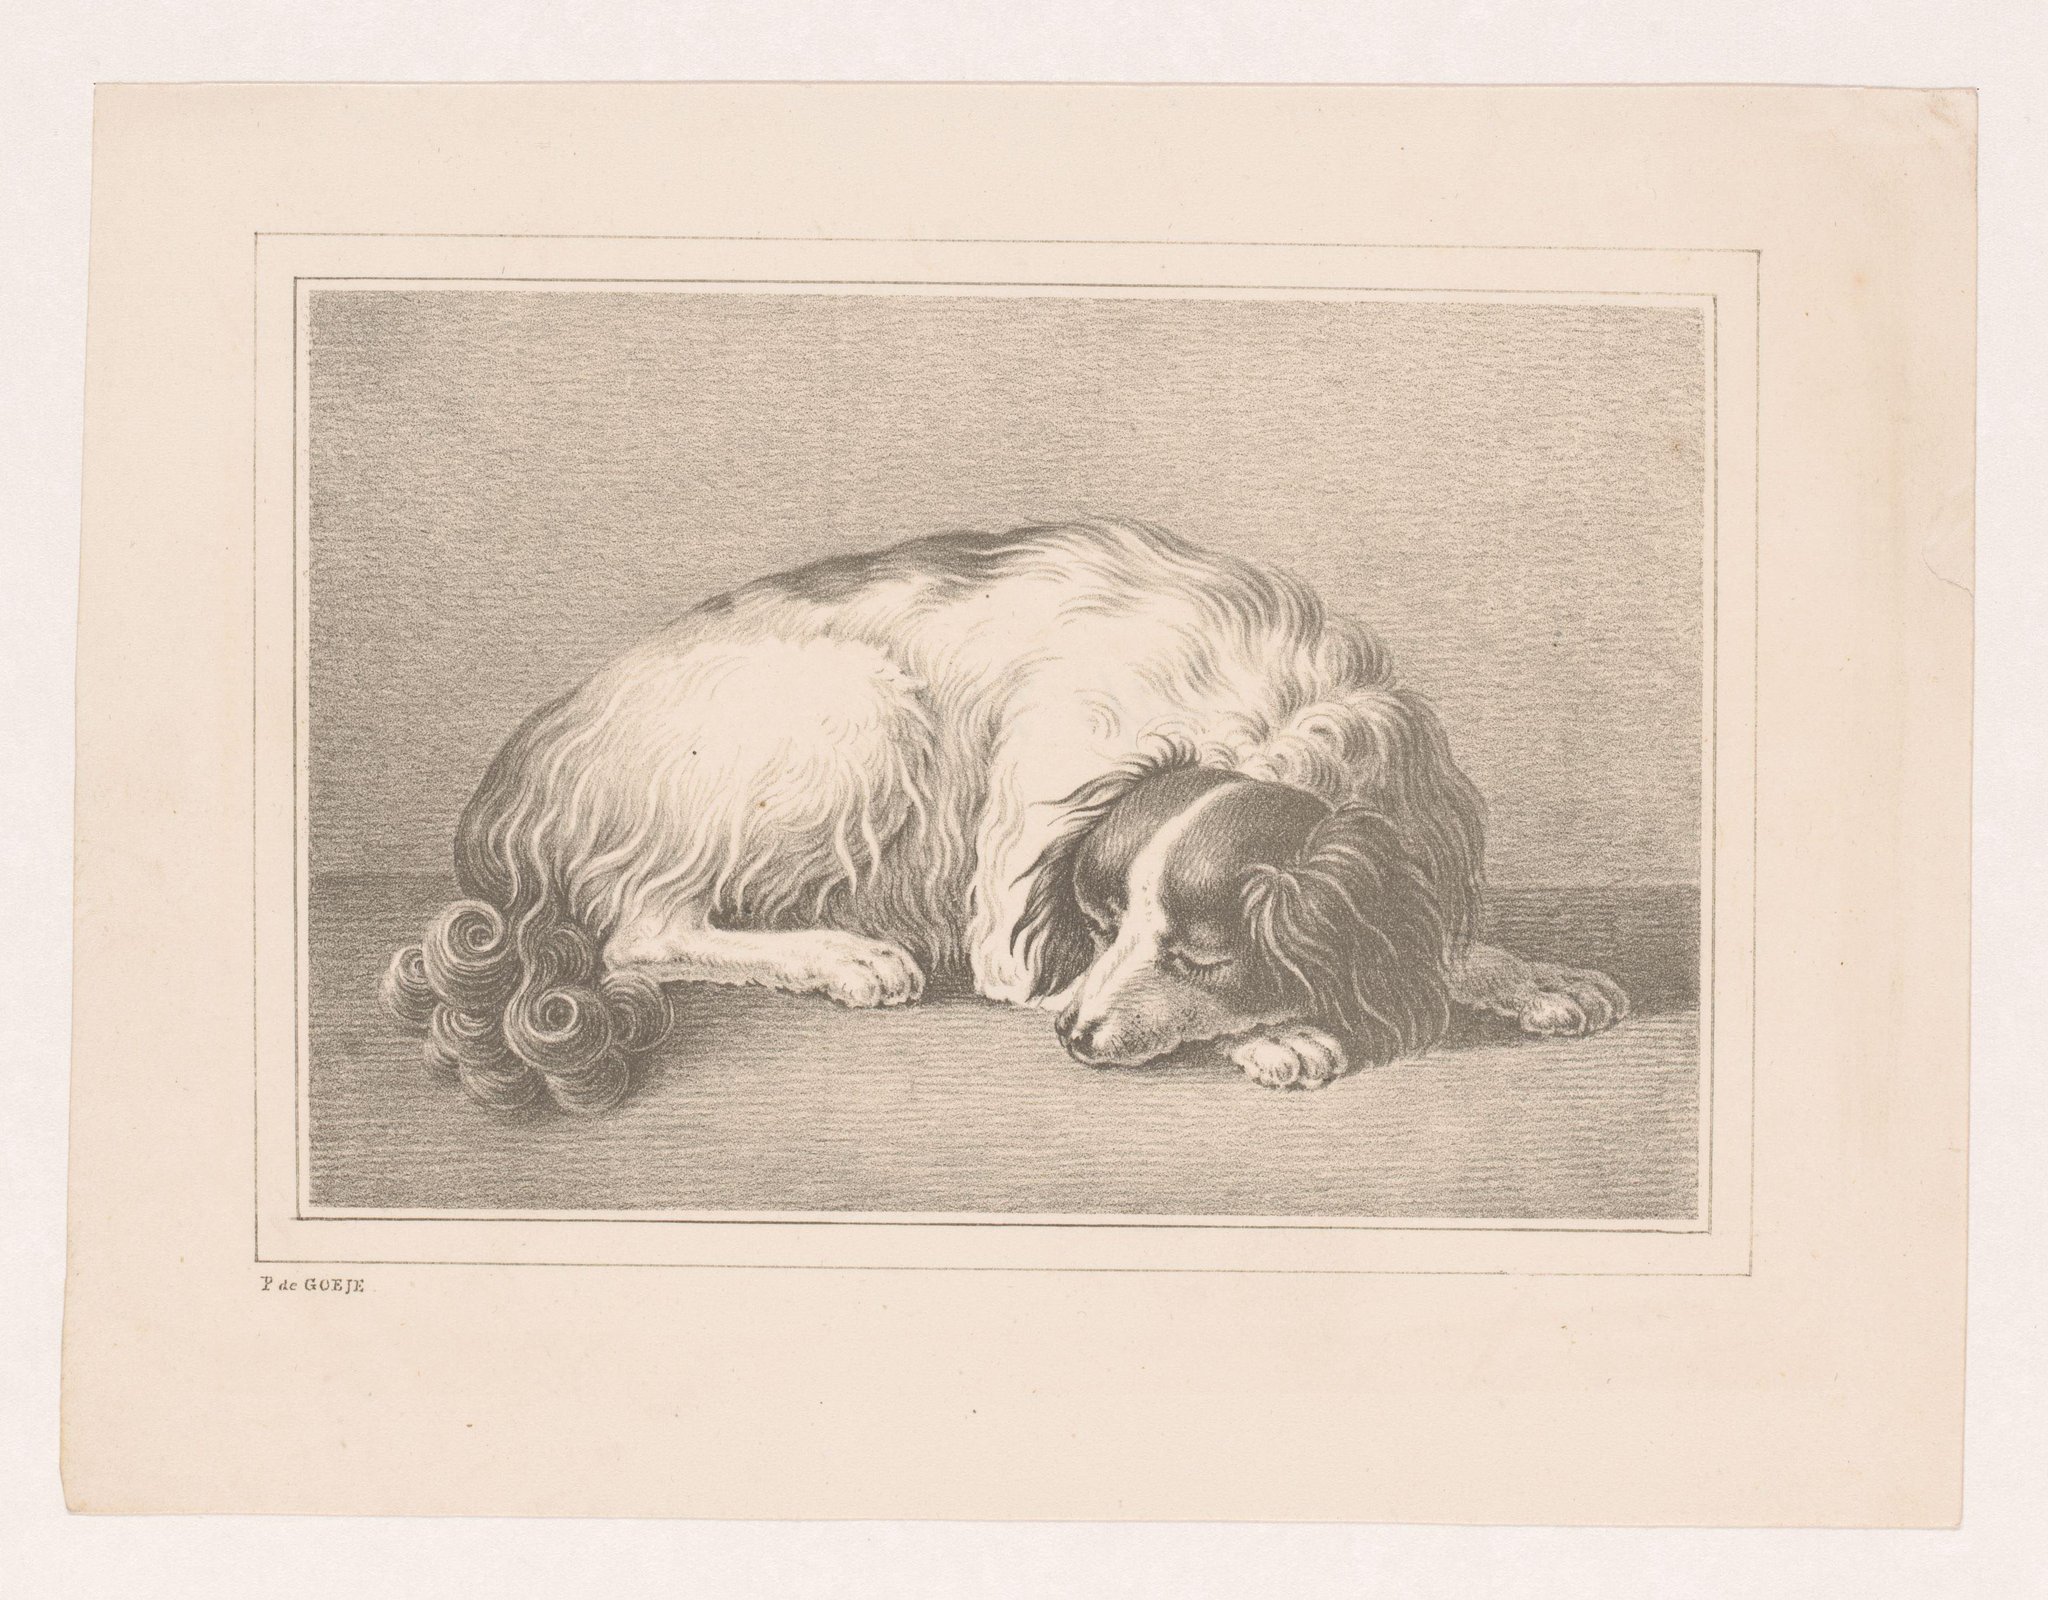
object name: print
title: Slapende hond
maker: pieter de goeje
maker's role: draughtsman, print maker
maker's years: 1789-1859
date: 1809-1859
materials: paper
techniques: lithograph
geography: netherlands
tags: sleeping on the ground, dog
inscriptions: collector's mark: Lugt 2228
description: De hond heeft krullen in zijn staart. Er loopt een witte streep over zijn kop.